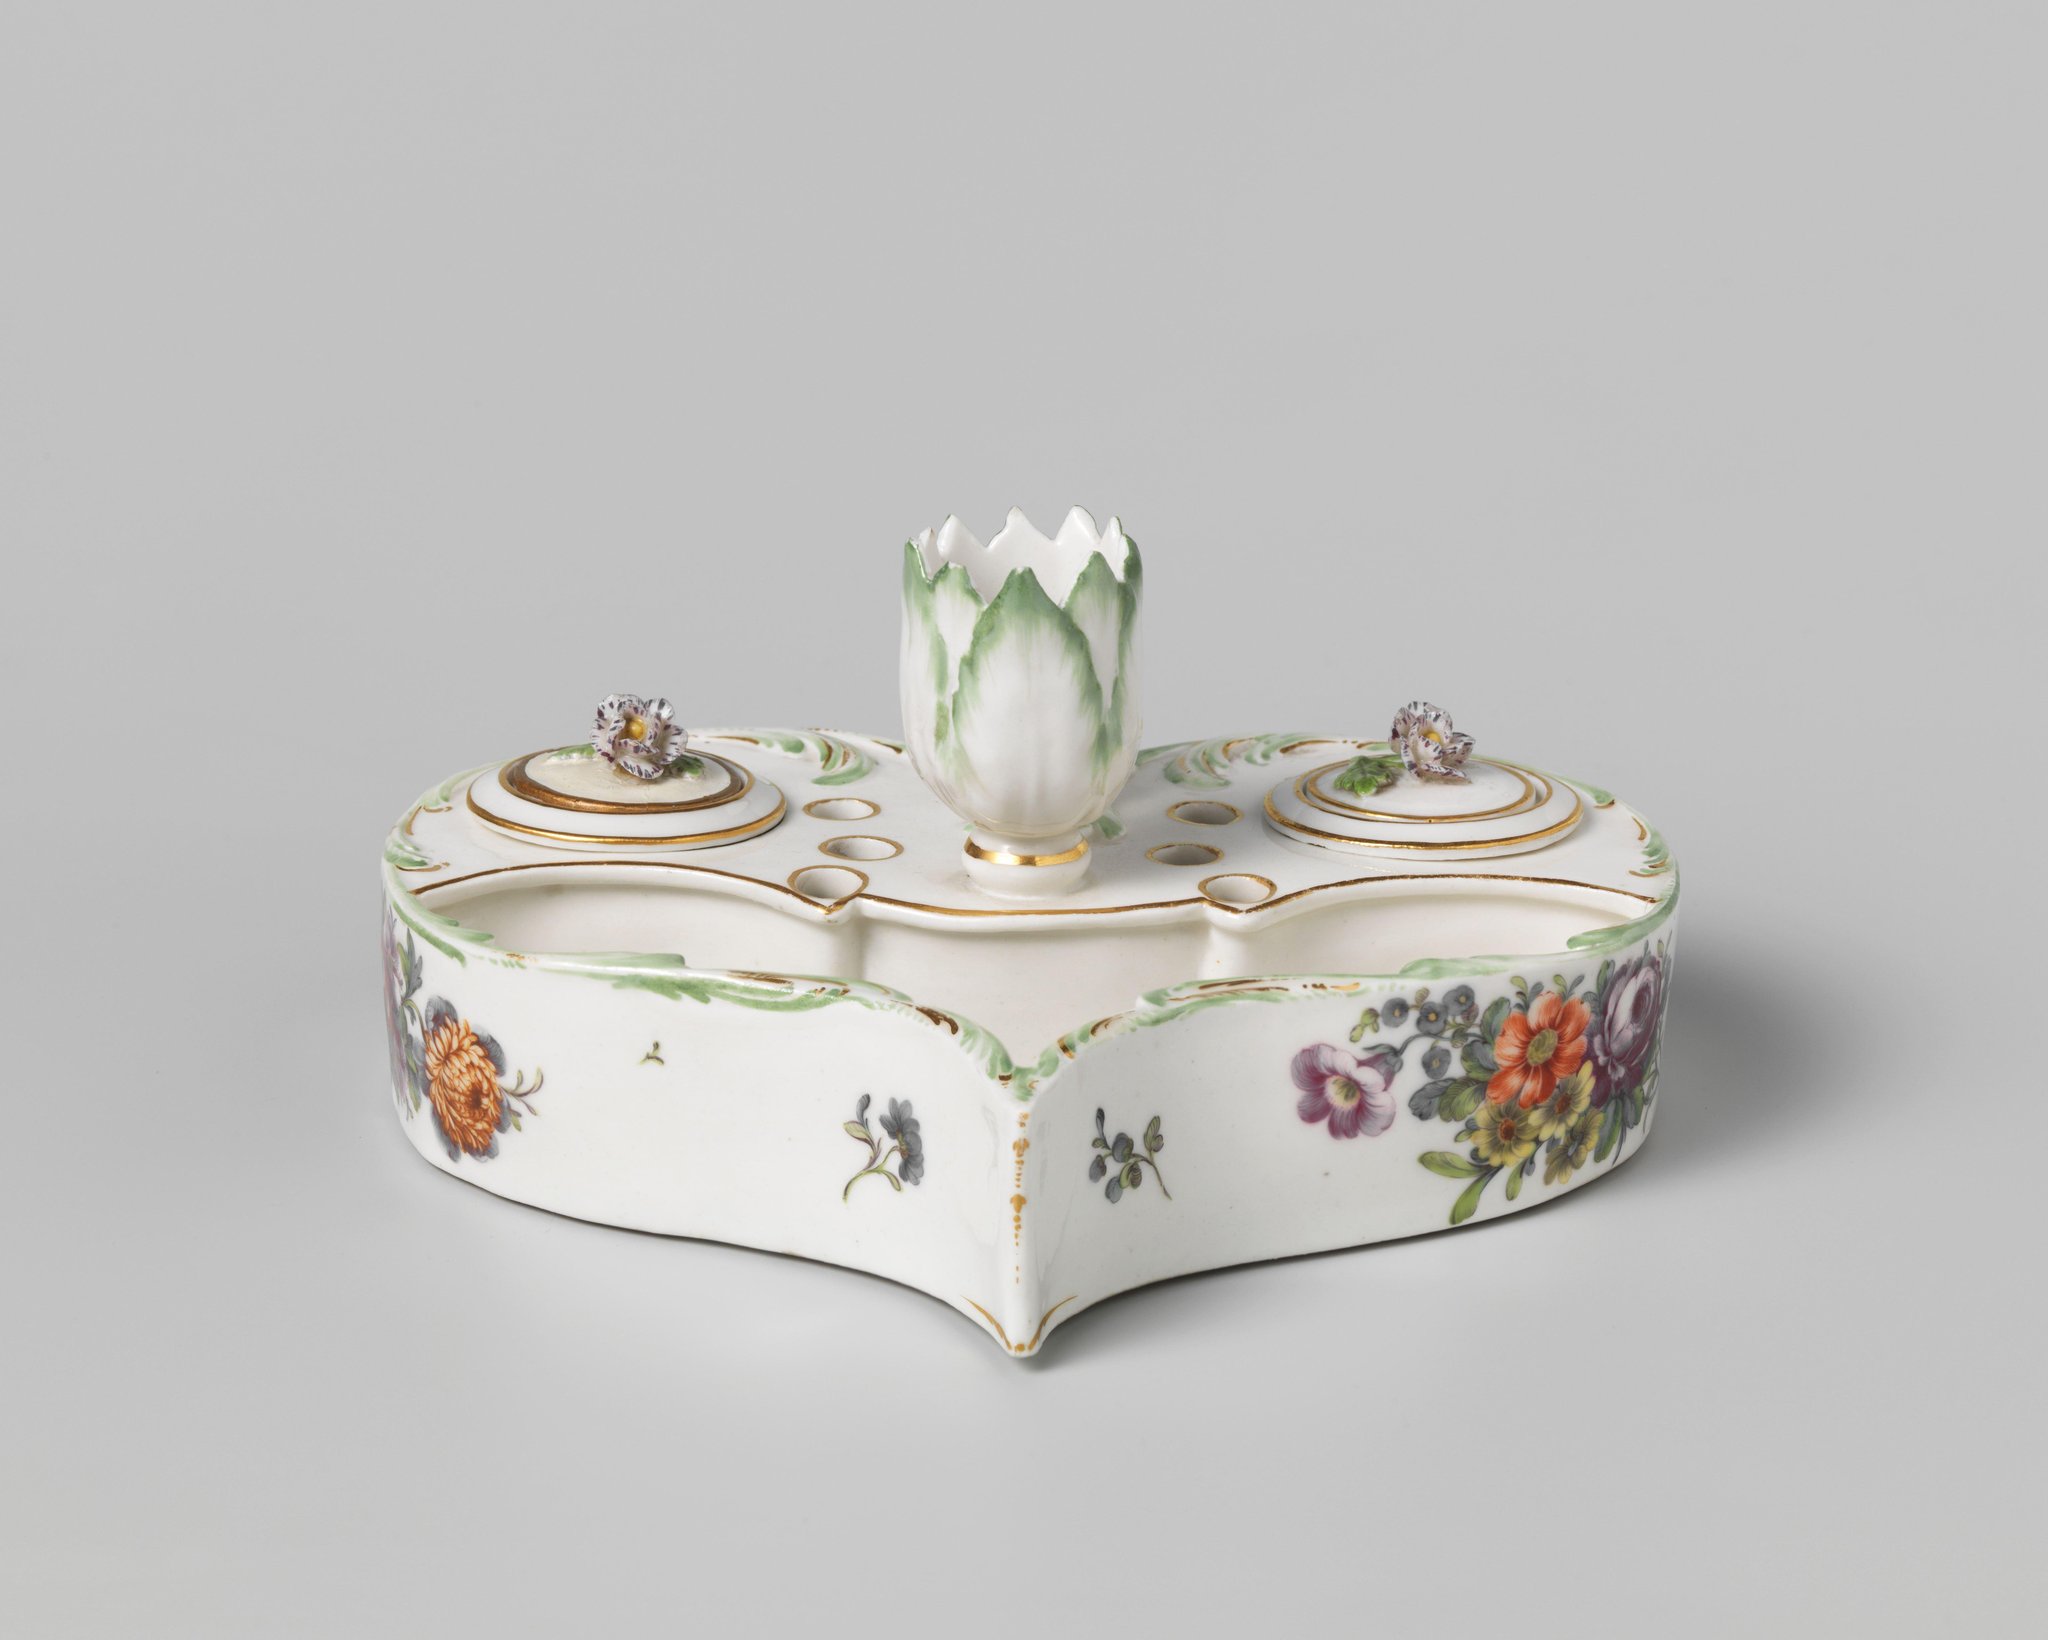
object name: inkstand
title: Inktstel, hartvormig, beschilderd met bloemboeketten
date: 1774-1778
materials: porcelain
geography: loosdrecht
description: Inkwell. Porcelain. Loosdrecht, c. 1774 - 1778. Factory of Joannes de Mol.